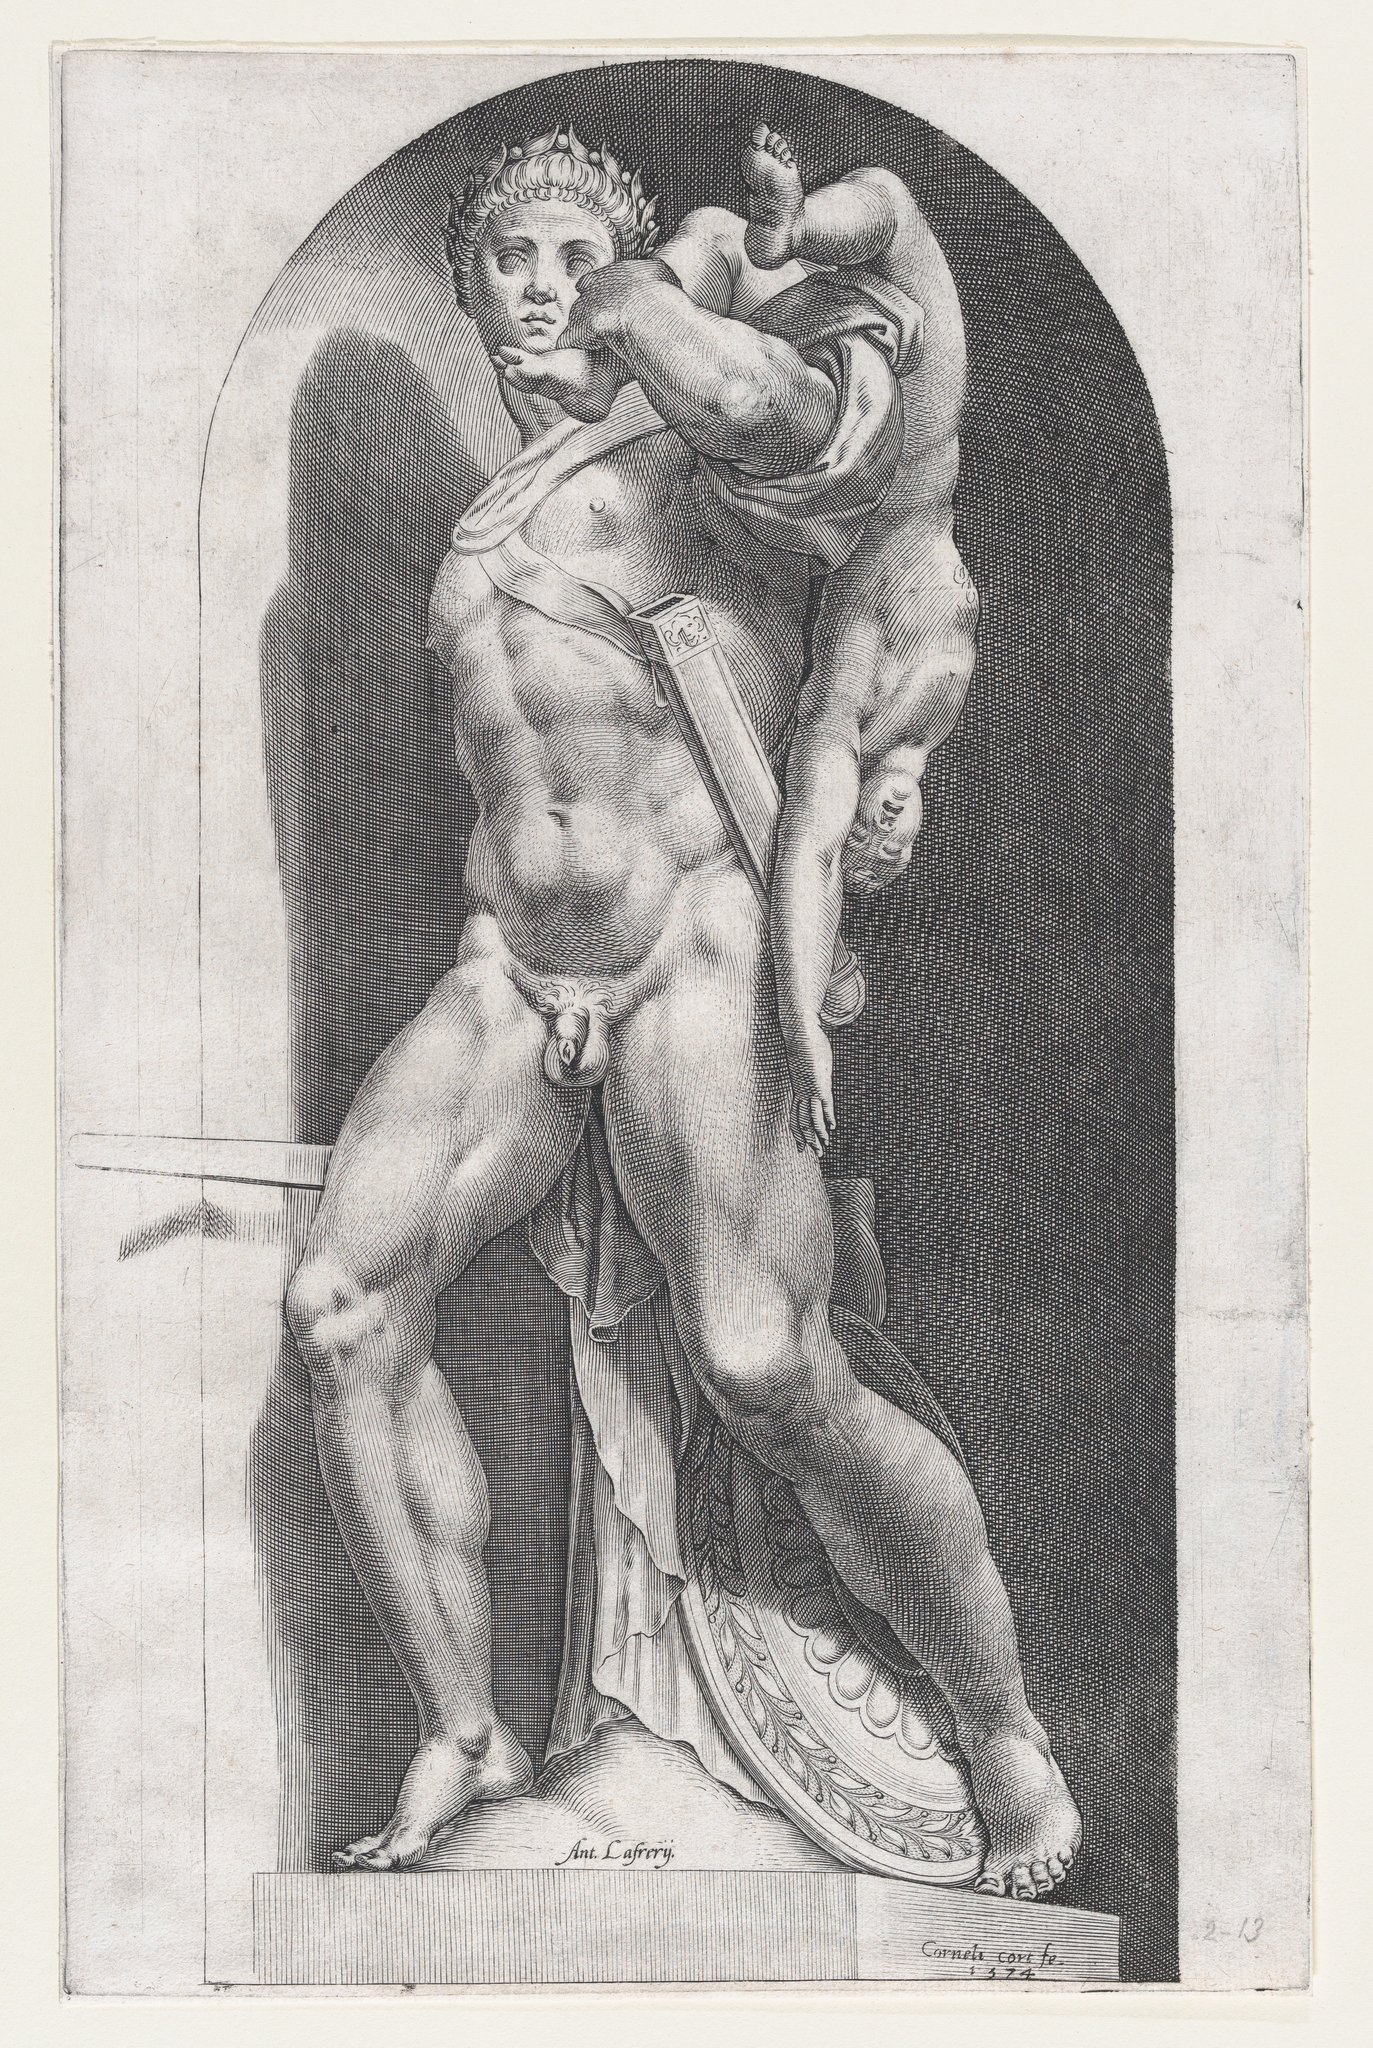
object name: print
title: Atreus Farnese, from "Speculum Romanae Magnificentiae"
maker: Anonymous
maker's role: artist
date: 1574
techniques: engraving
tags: male nudes